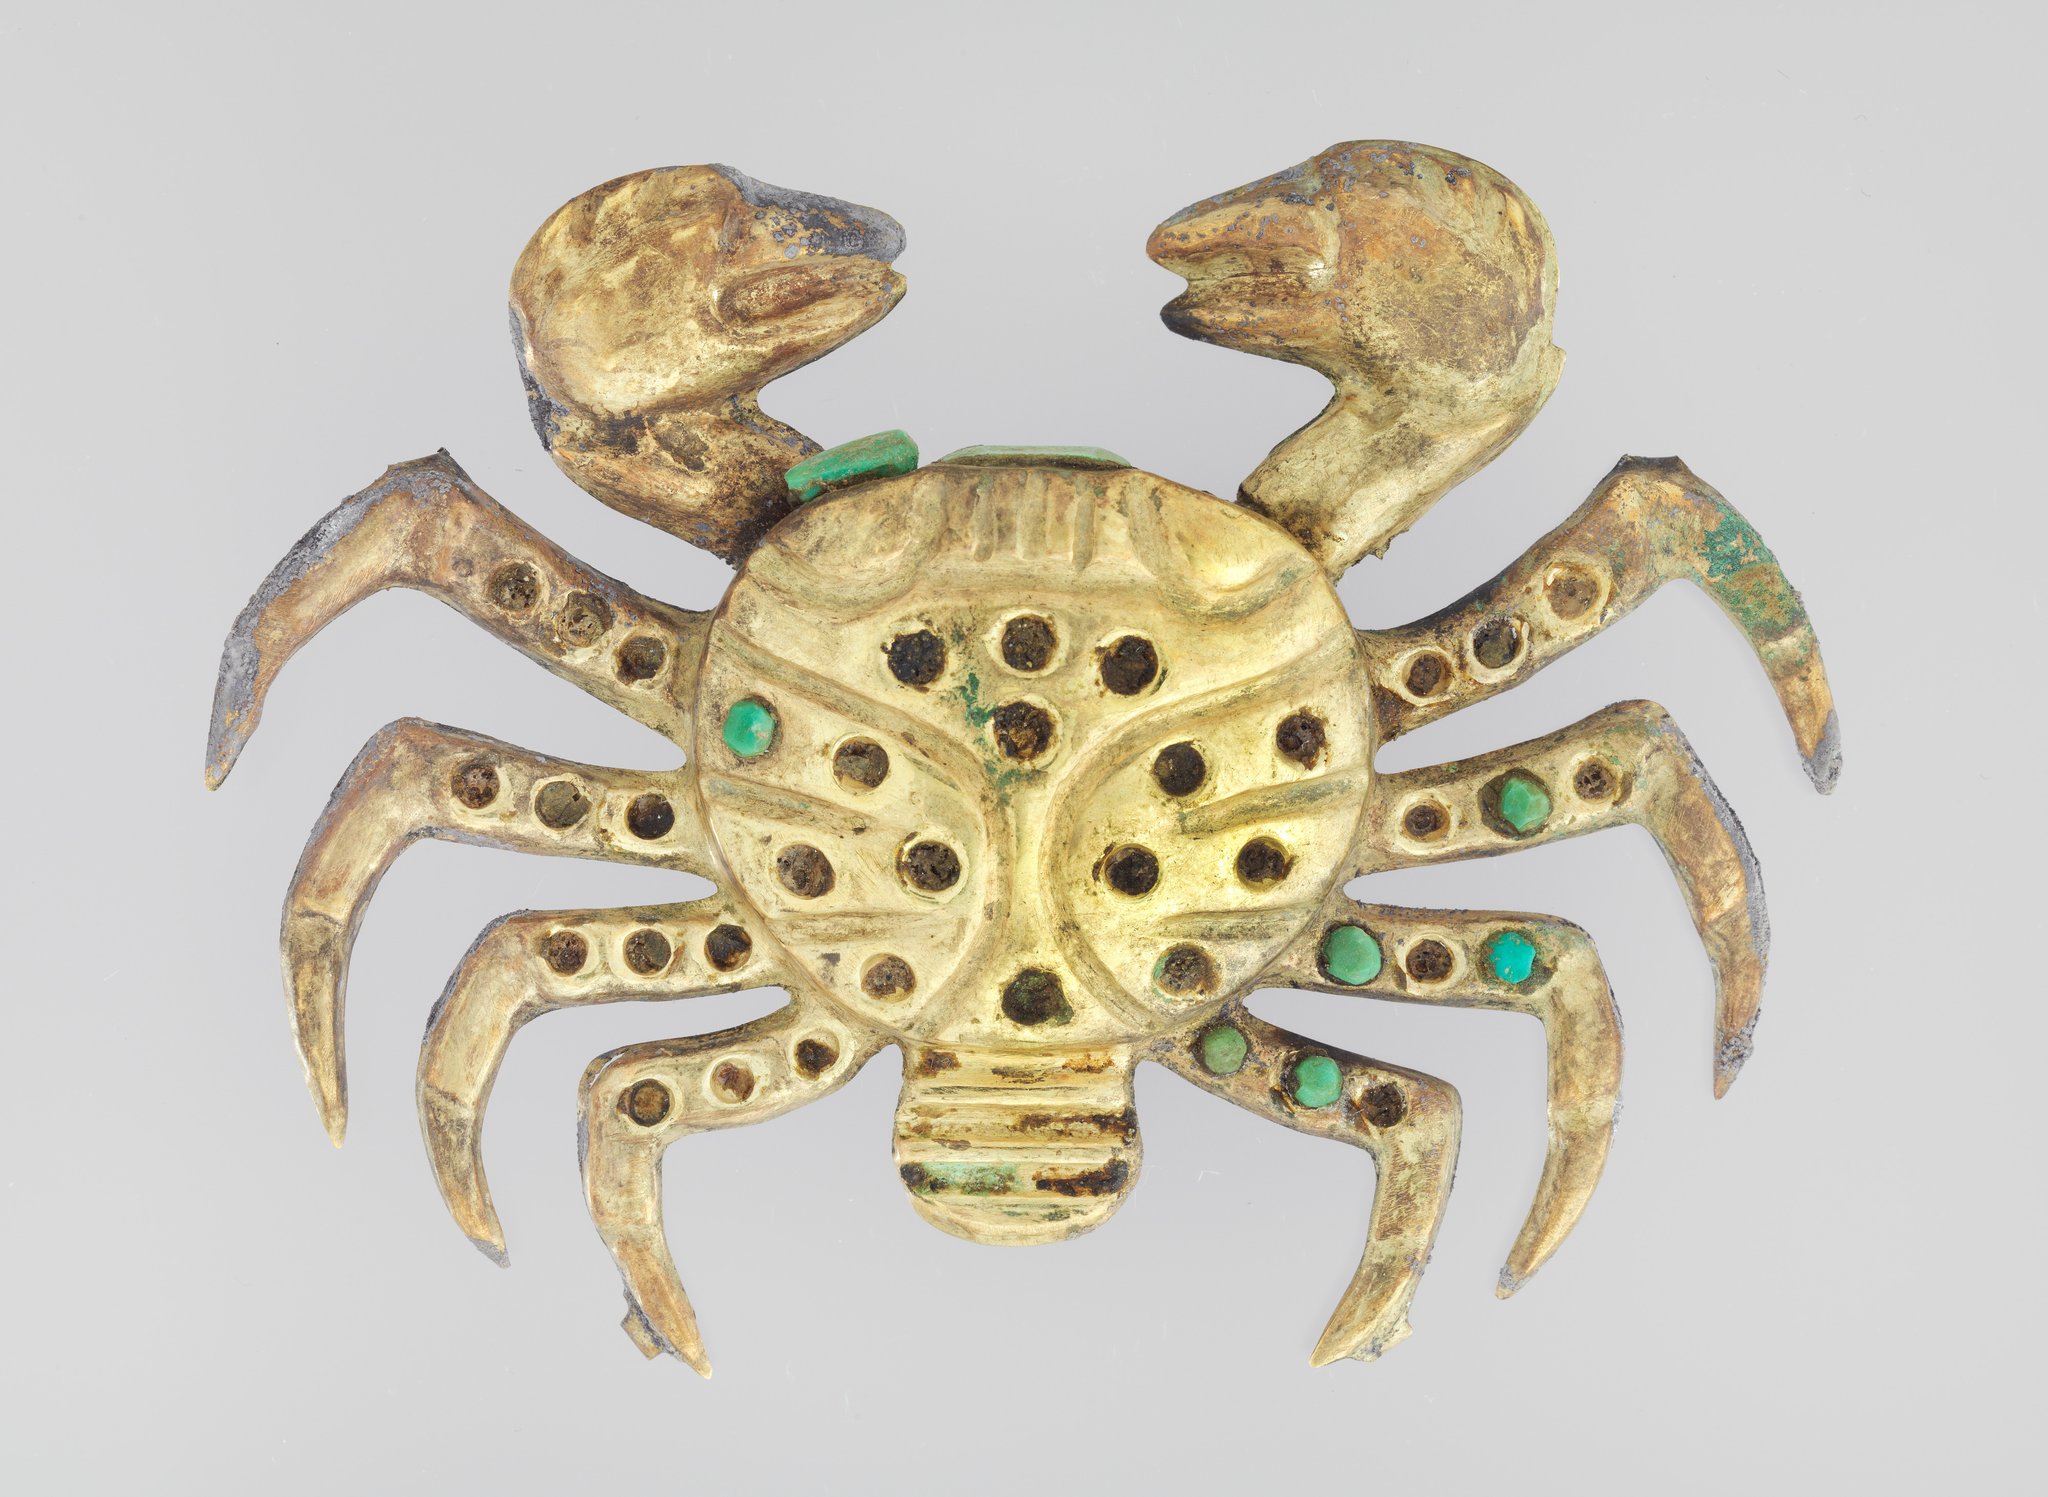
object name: ornament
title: Ornament Frontal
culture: moche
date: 501-700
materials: gold, stone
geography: peru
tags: crabs